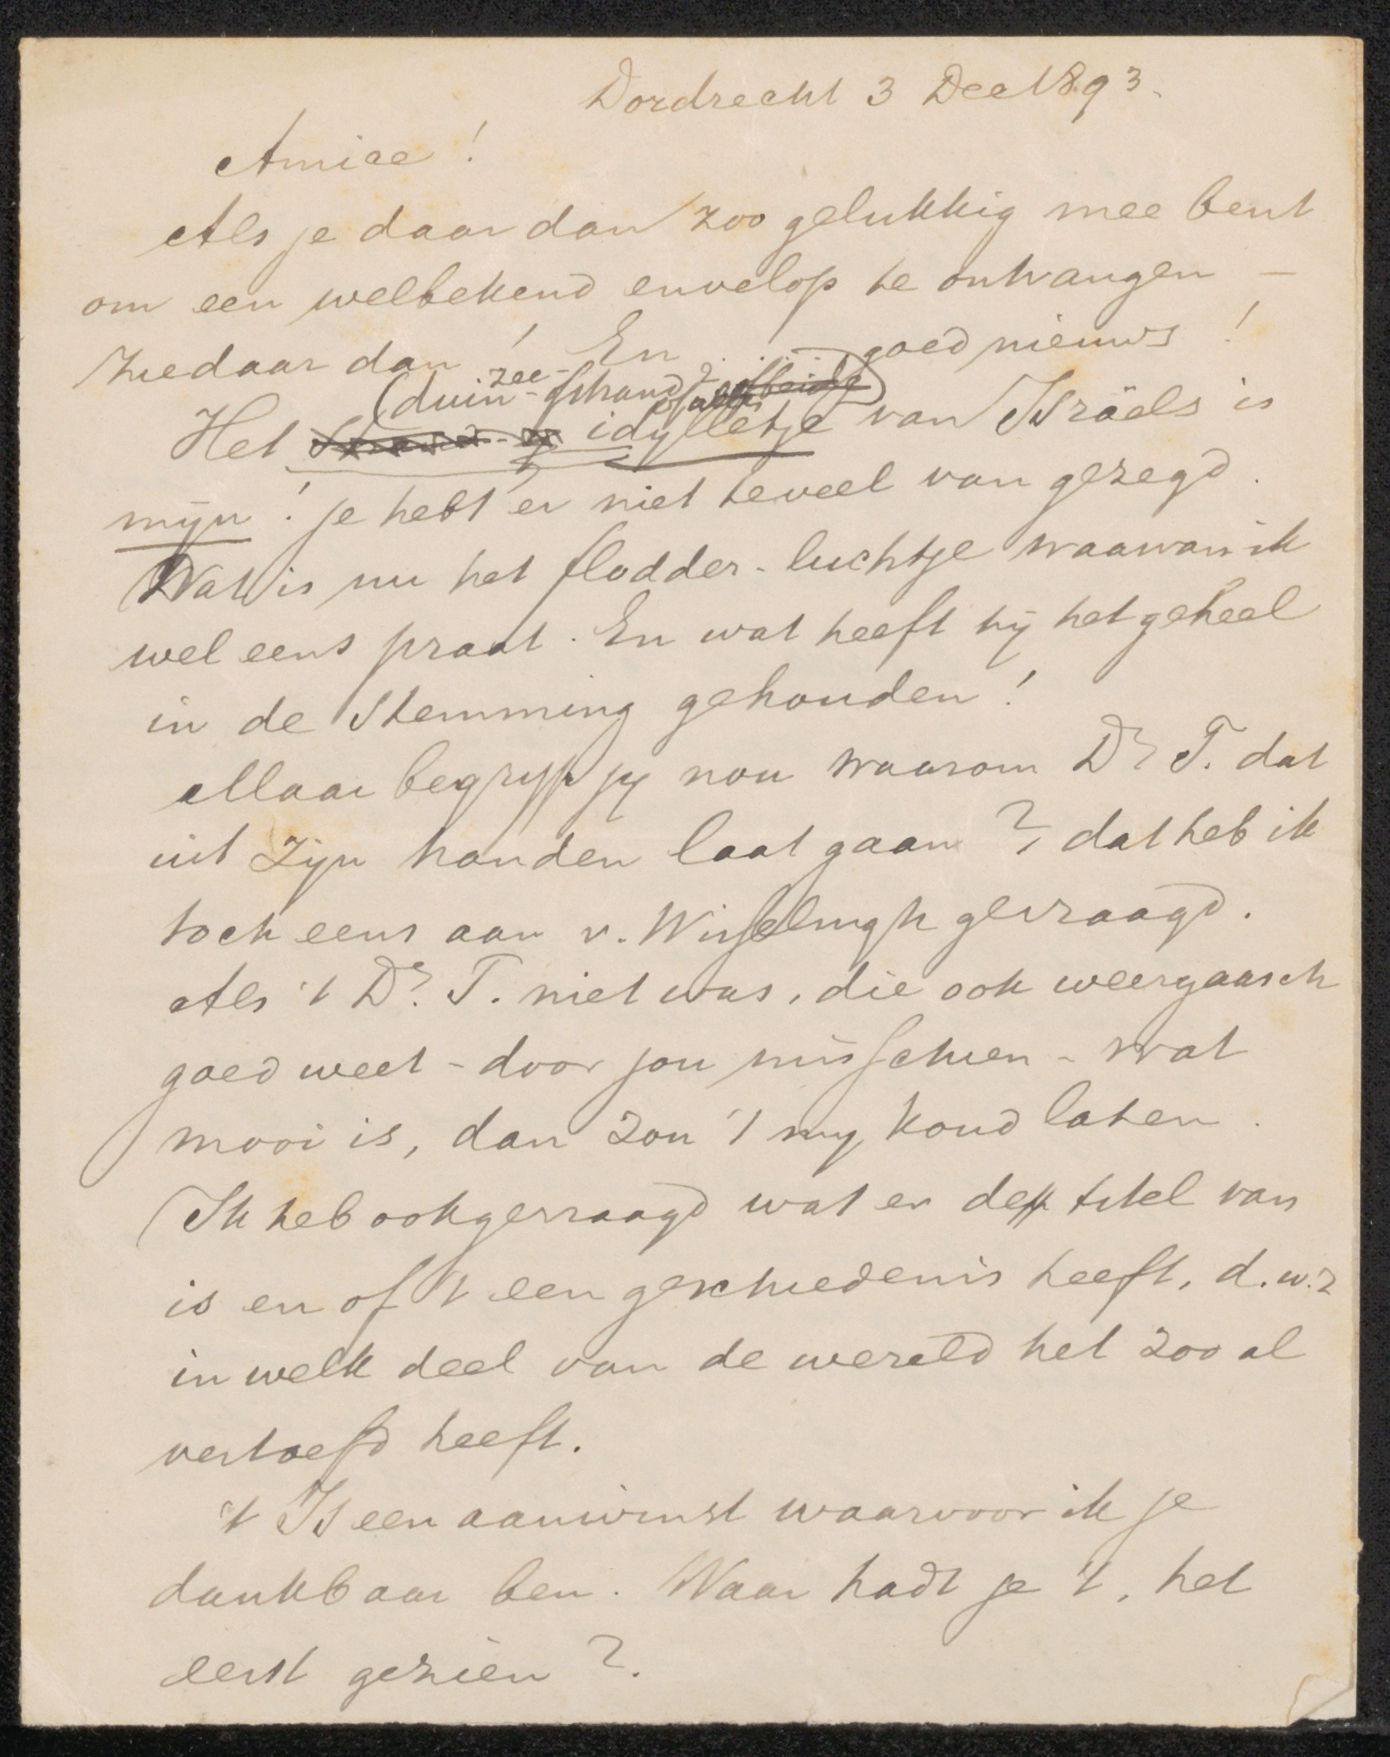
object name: letter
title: Brief aan Jan Veth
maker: martinus cornelis lebret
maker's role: verzamelaar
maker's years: 1833-1894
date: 1893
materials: ink, paper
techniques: pen, writing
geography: dordrecht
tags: painter, print maker, jozef israëls, designer, jan veth, arnhem, anton mauve, maurits van der valk, etienne bosch, haarlem, anton l. koster, marius bauer, willem de zwart, lyon, paris, jean louis ernest meissonier, elbert jan van wisselingh, amsterdam, draughtsman, hermanus gijsbertus tersteeg, art trade, art shop, the graphic arts, painting (including book-illumination, miniature-painting), diseases, art collecting, money, london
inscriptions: collector's mark: ‘RPK’